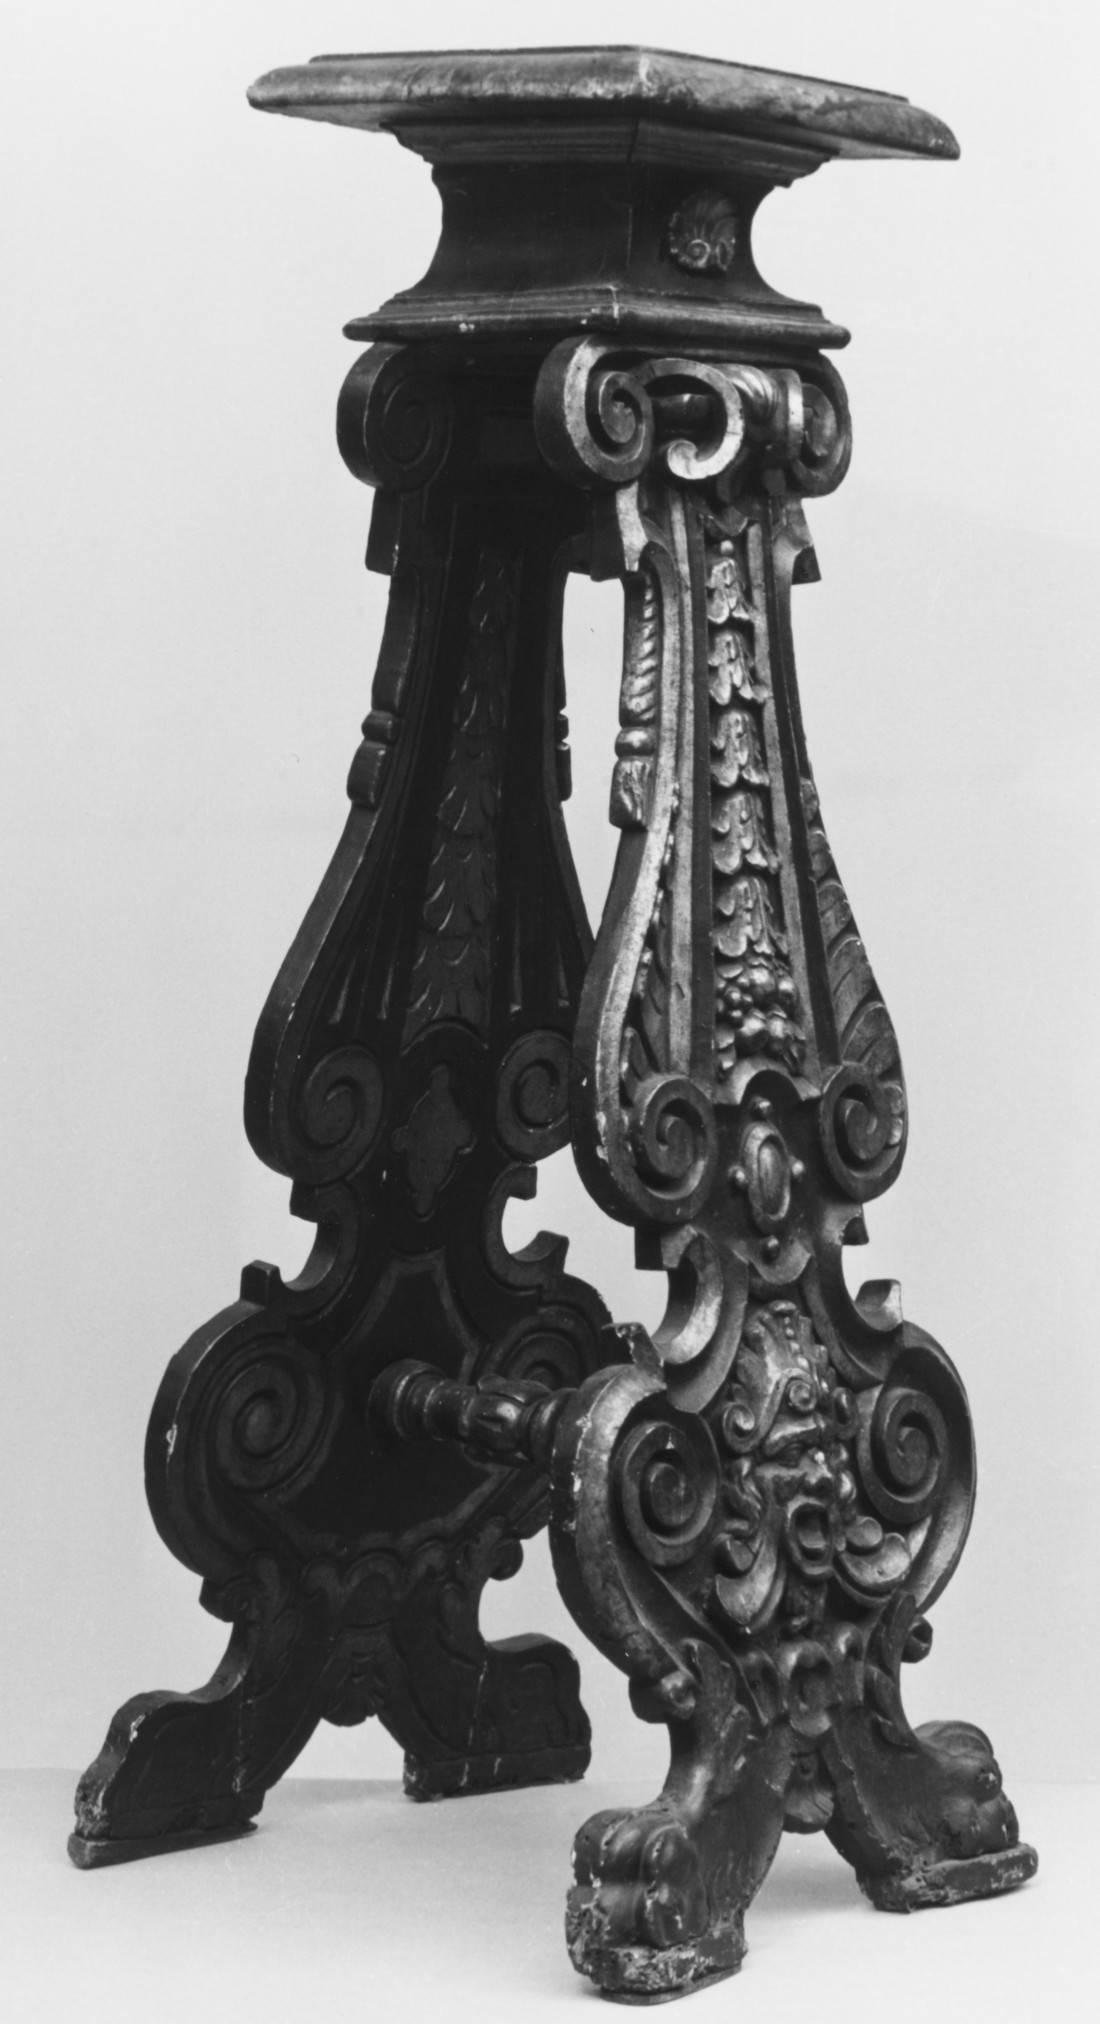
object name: pedestal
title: Pedestal (one of a pair)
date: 1567-1600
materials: gilt, wood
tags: grotesques,acanthus